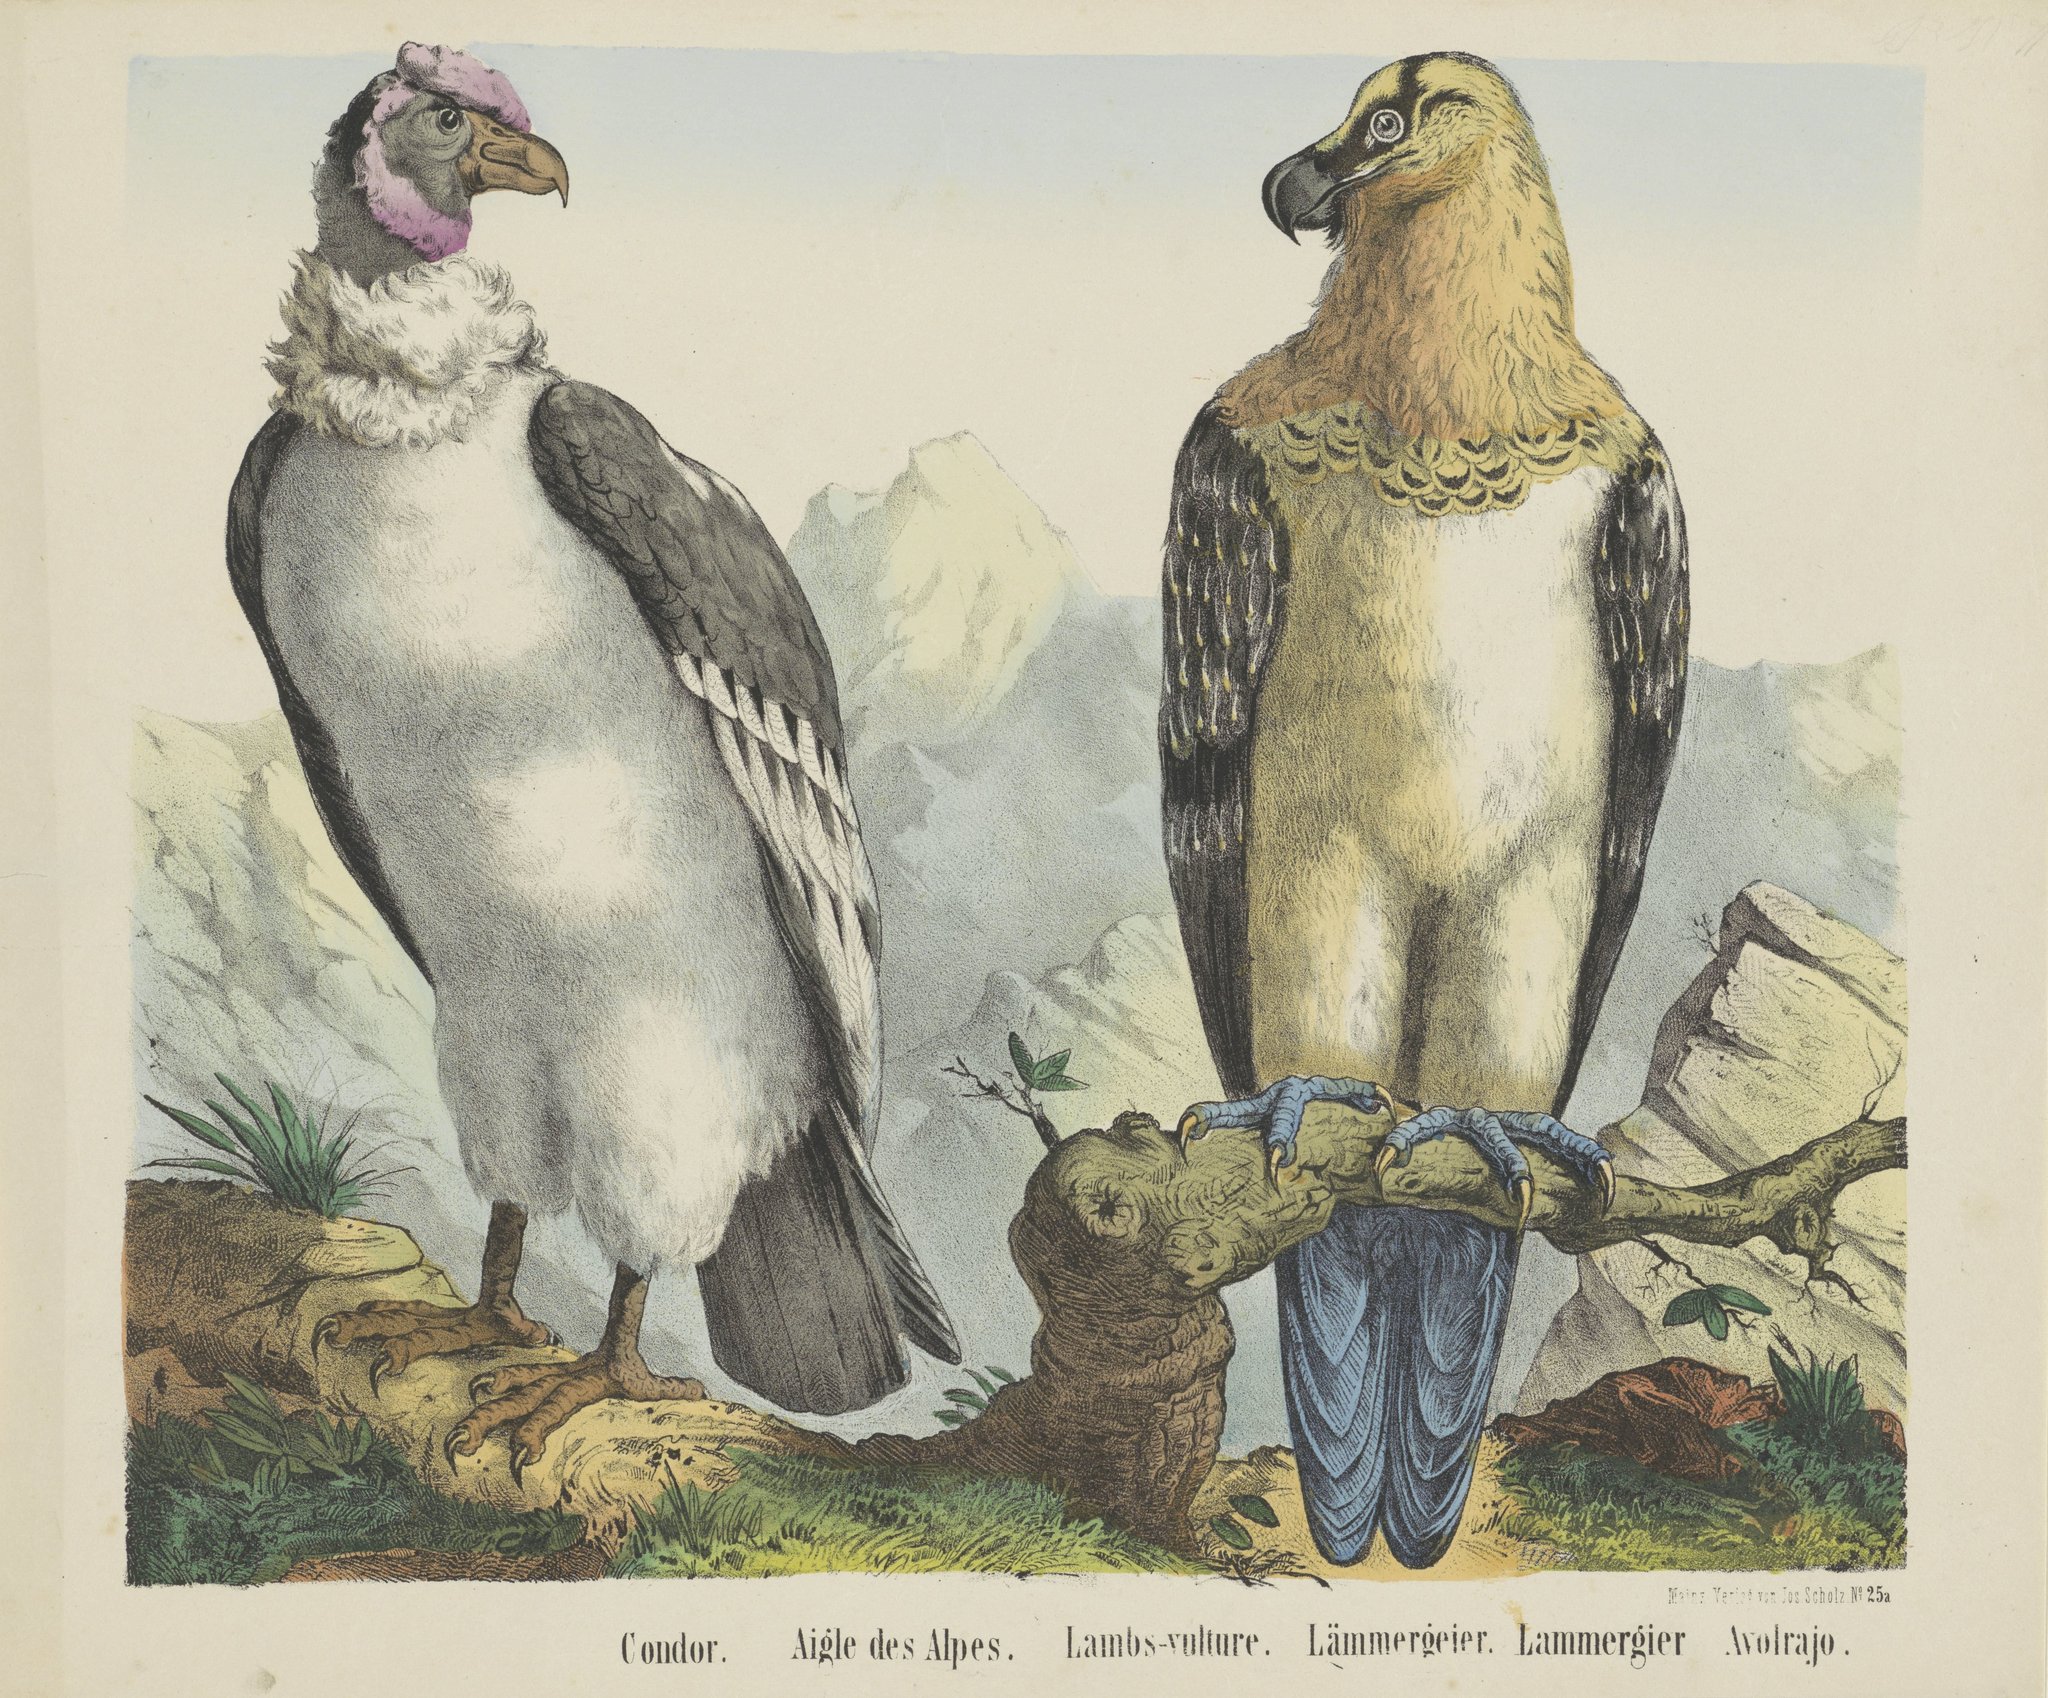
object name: print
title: Condor. / Aigle des Alpes. / Lambs-vulture. / Lämmergeier. / Lammergier / Avolrajo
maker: Anonymous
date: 1829-1880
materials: paper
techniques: colour, letterpress printing, lithograph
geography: europe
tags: predatory birds: vulture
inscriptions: collector's mark: Lugt 2760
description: Twee gieren, waarvan één op een tak, in een berglandschap. Genummerd rechtsonder: No. 25a.